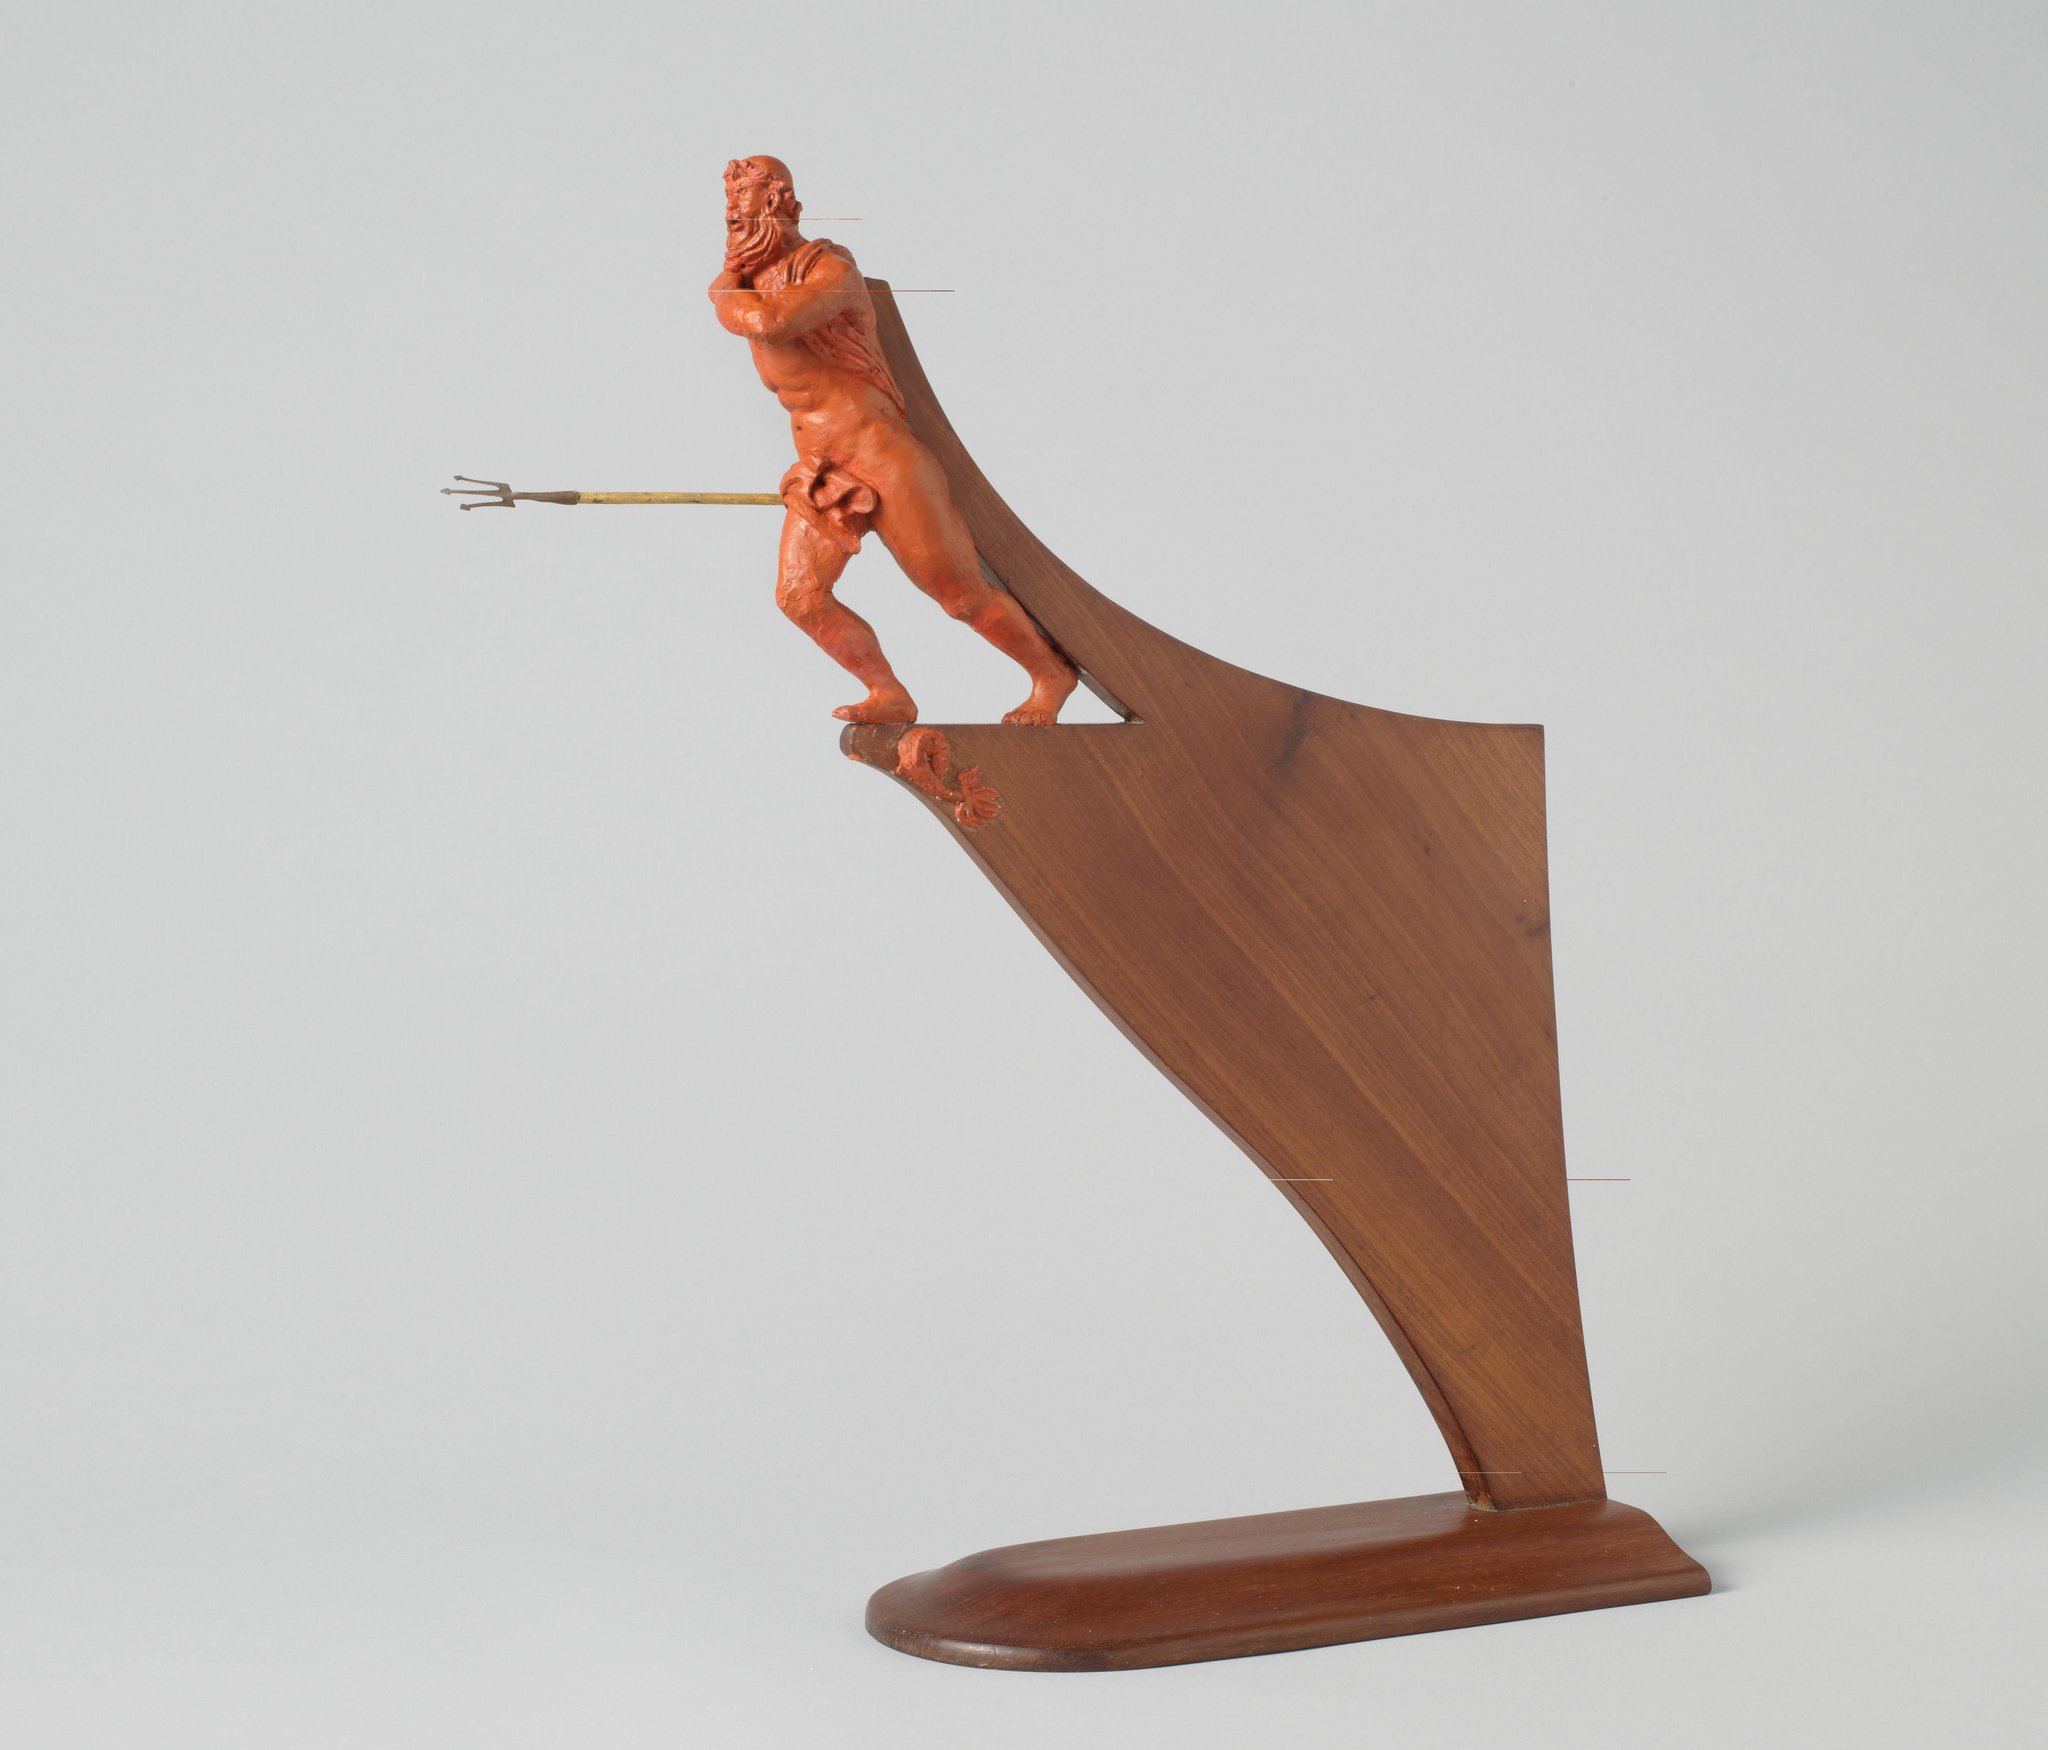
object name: scale model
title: Model of a figurehead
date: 1820-1830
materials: copper, wax, wood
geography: flushing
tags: (story of) neptune (poseidon)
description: Het model werd vervaardigd voor het linieschip van 84 stukken Neptunus, lang 57.8 m, gebouwd door C. Soetermeer te Vlissingen in 1821-1835. Het schip werd herdoopt Koning der Nederlanden in 1844 en was de laatste driedekker van de Nederlandse Marine. In 1858 werd zij omgebouwd tot drijvende batterij van 32 stukken en weer herdoopt Neptunus; in 1876 afgevoerd.